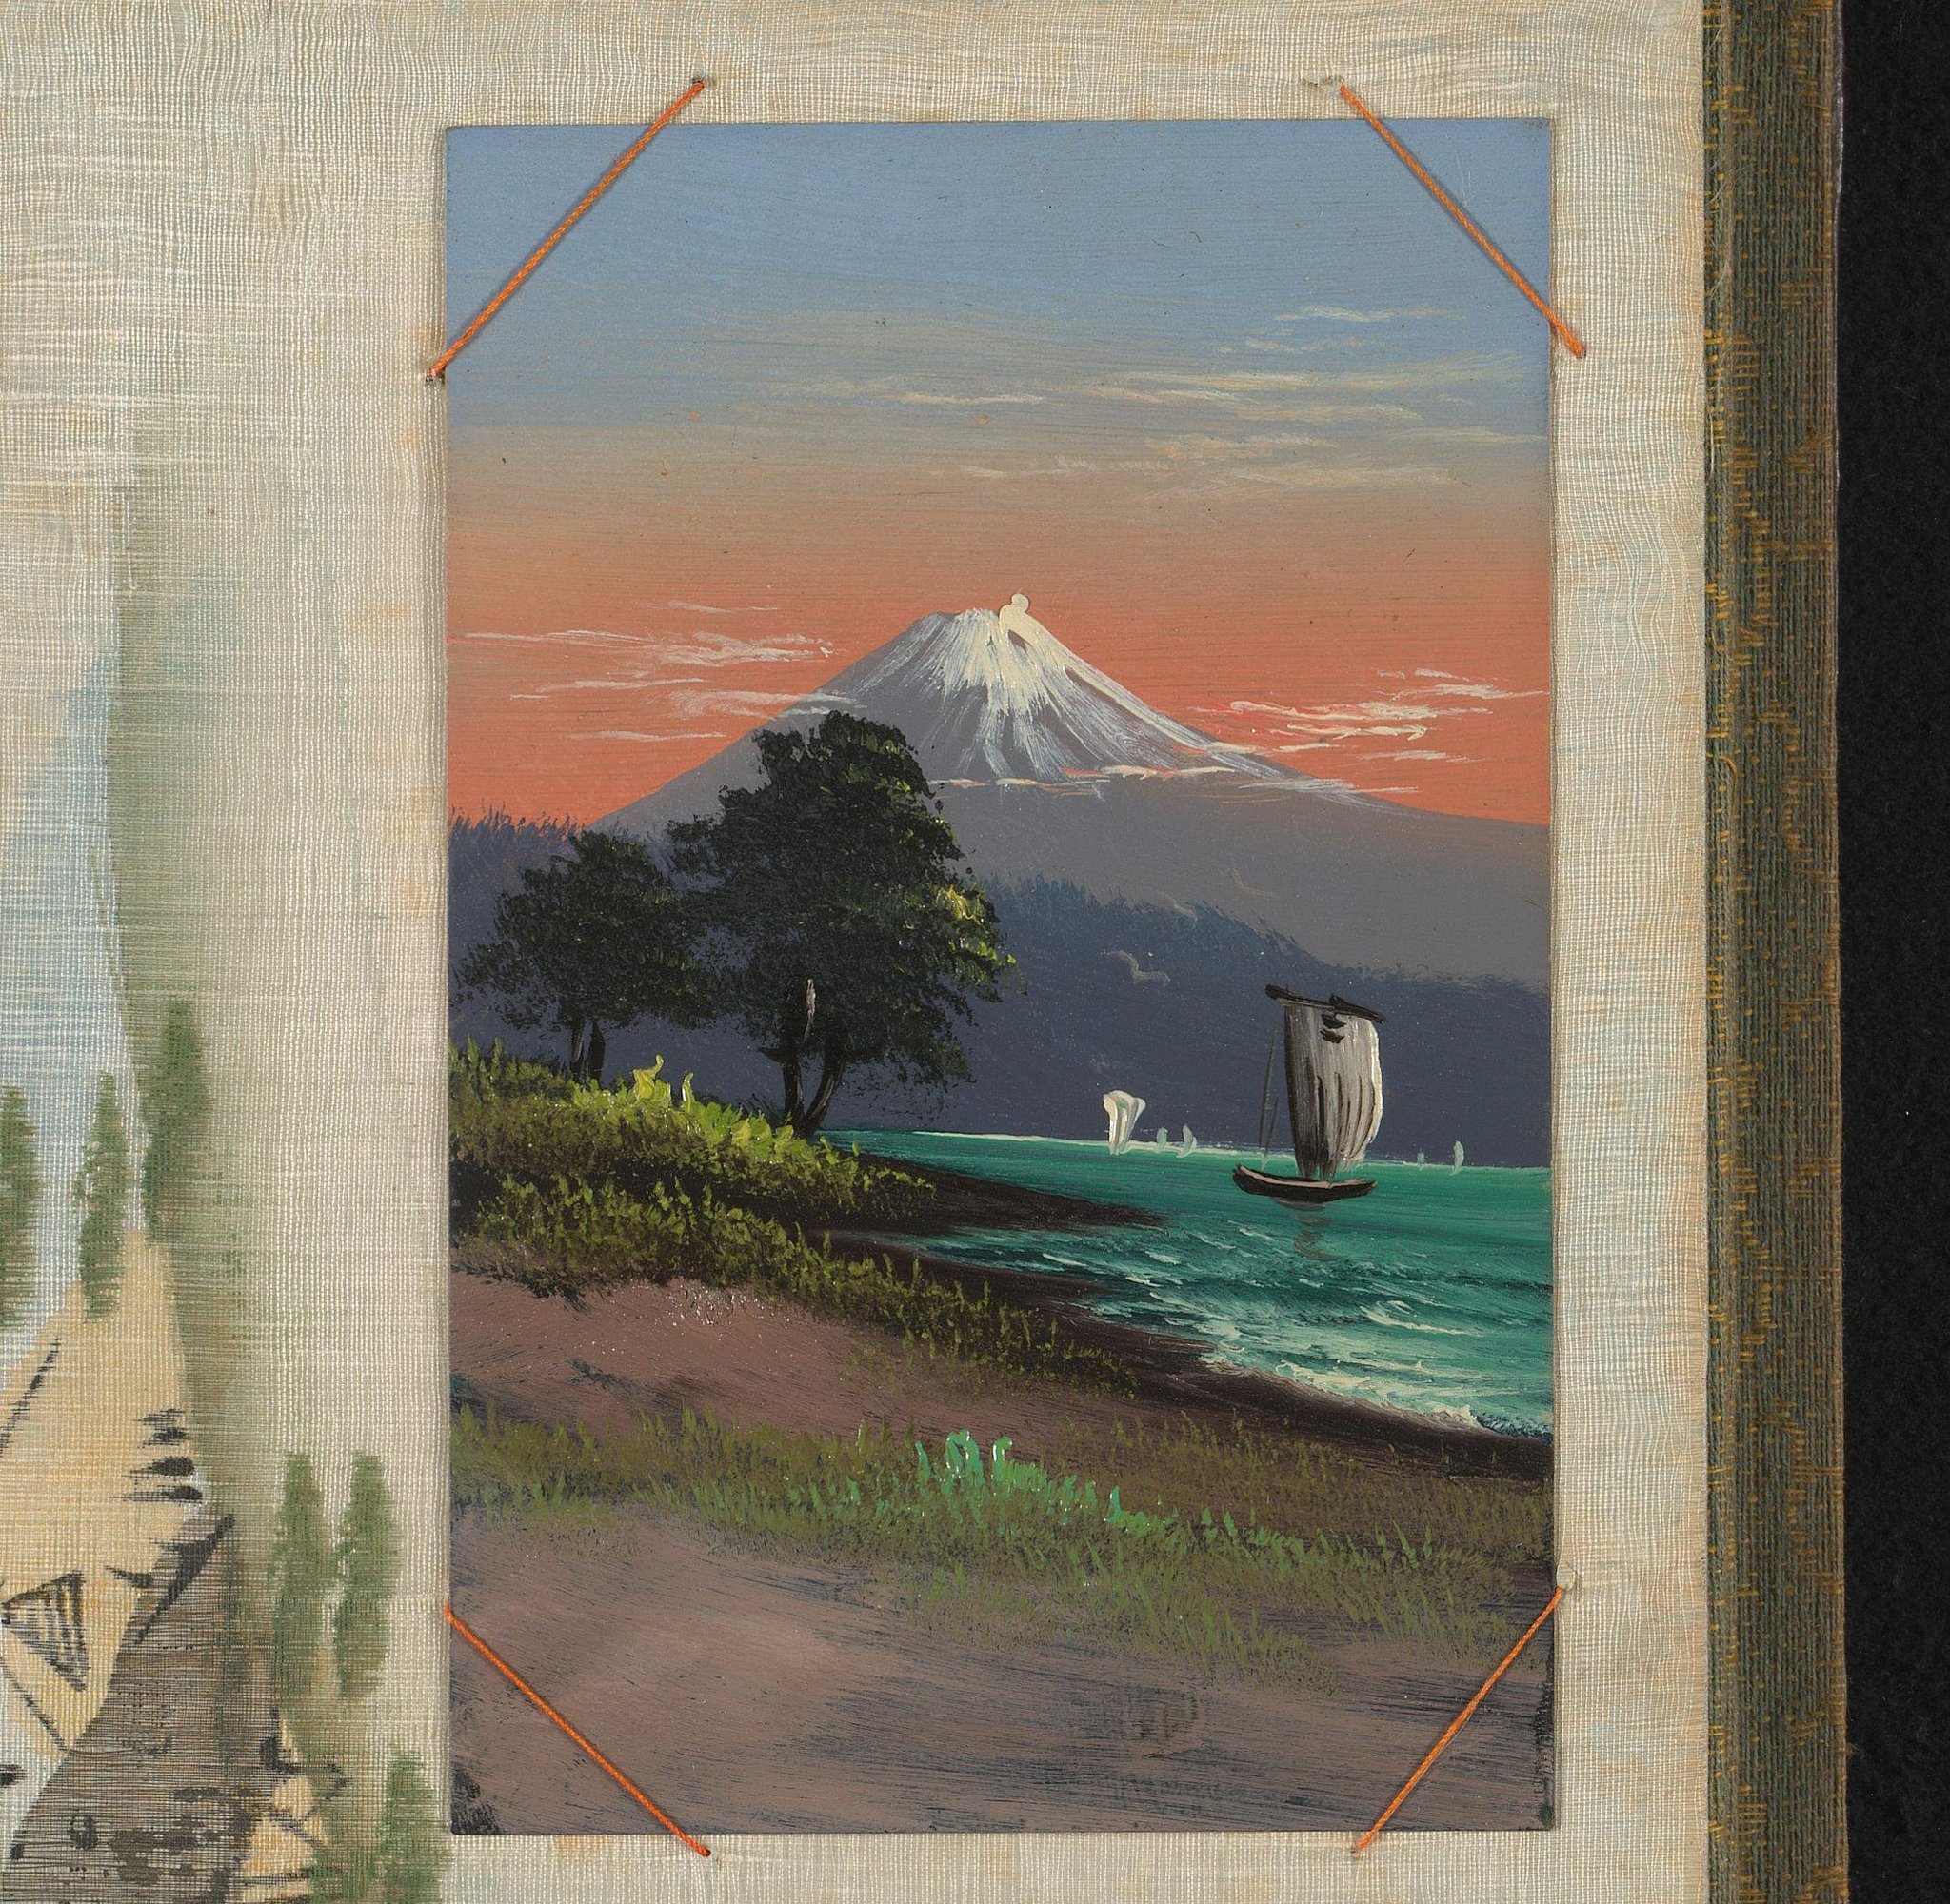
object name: drawing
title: Gezicht op een meer met enkele zeilboten met op de achtergrond een besneeuwde berg, vermoedelijk in Japan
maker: Anonymous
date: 1870-1900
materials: cardboard, paint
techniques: brush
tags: sailing-ship, sailing-boat, mountain-top, peak, lake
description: Deze tekening maakt deel uit van een album.